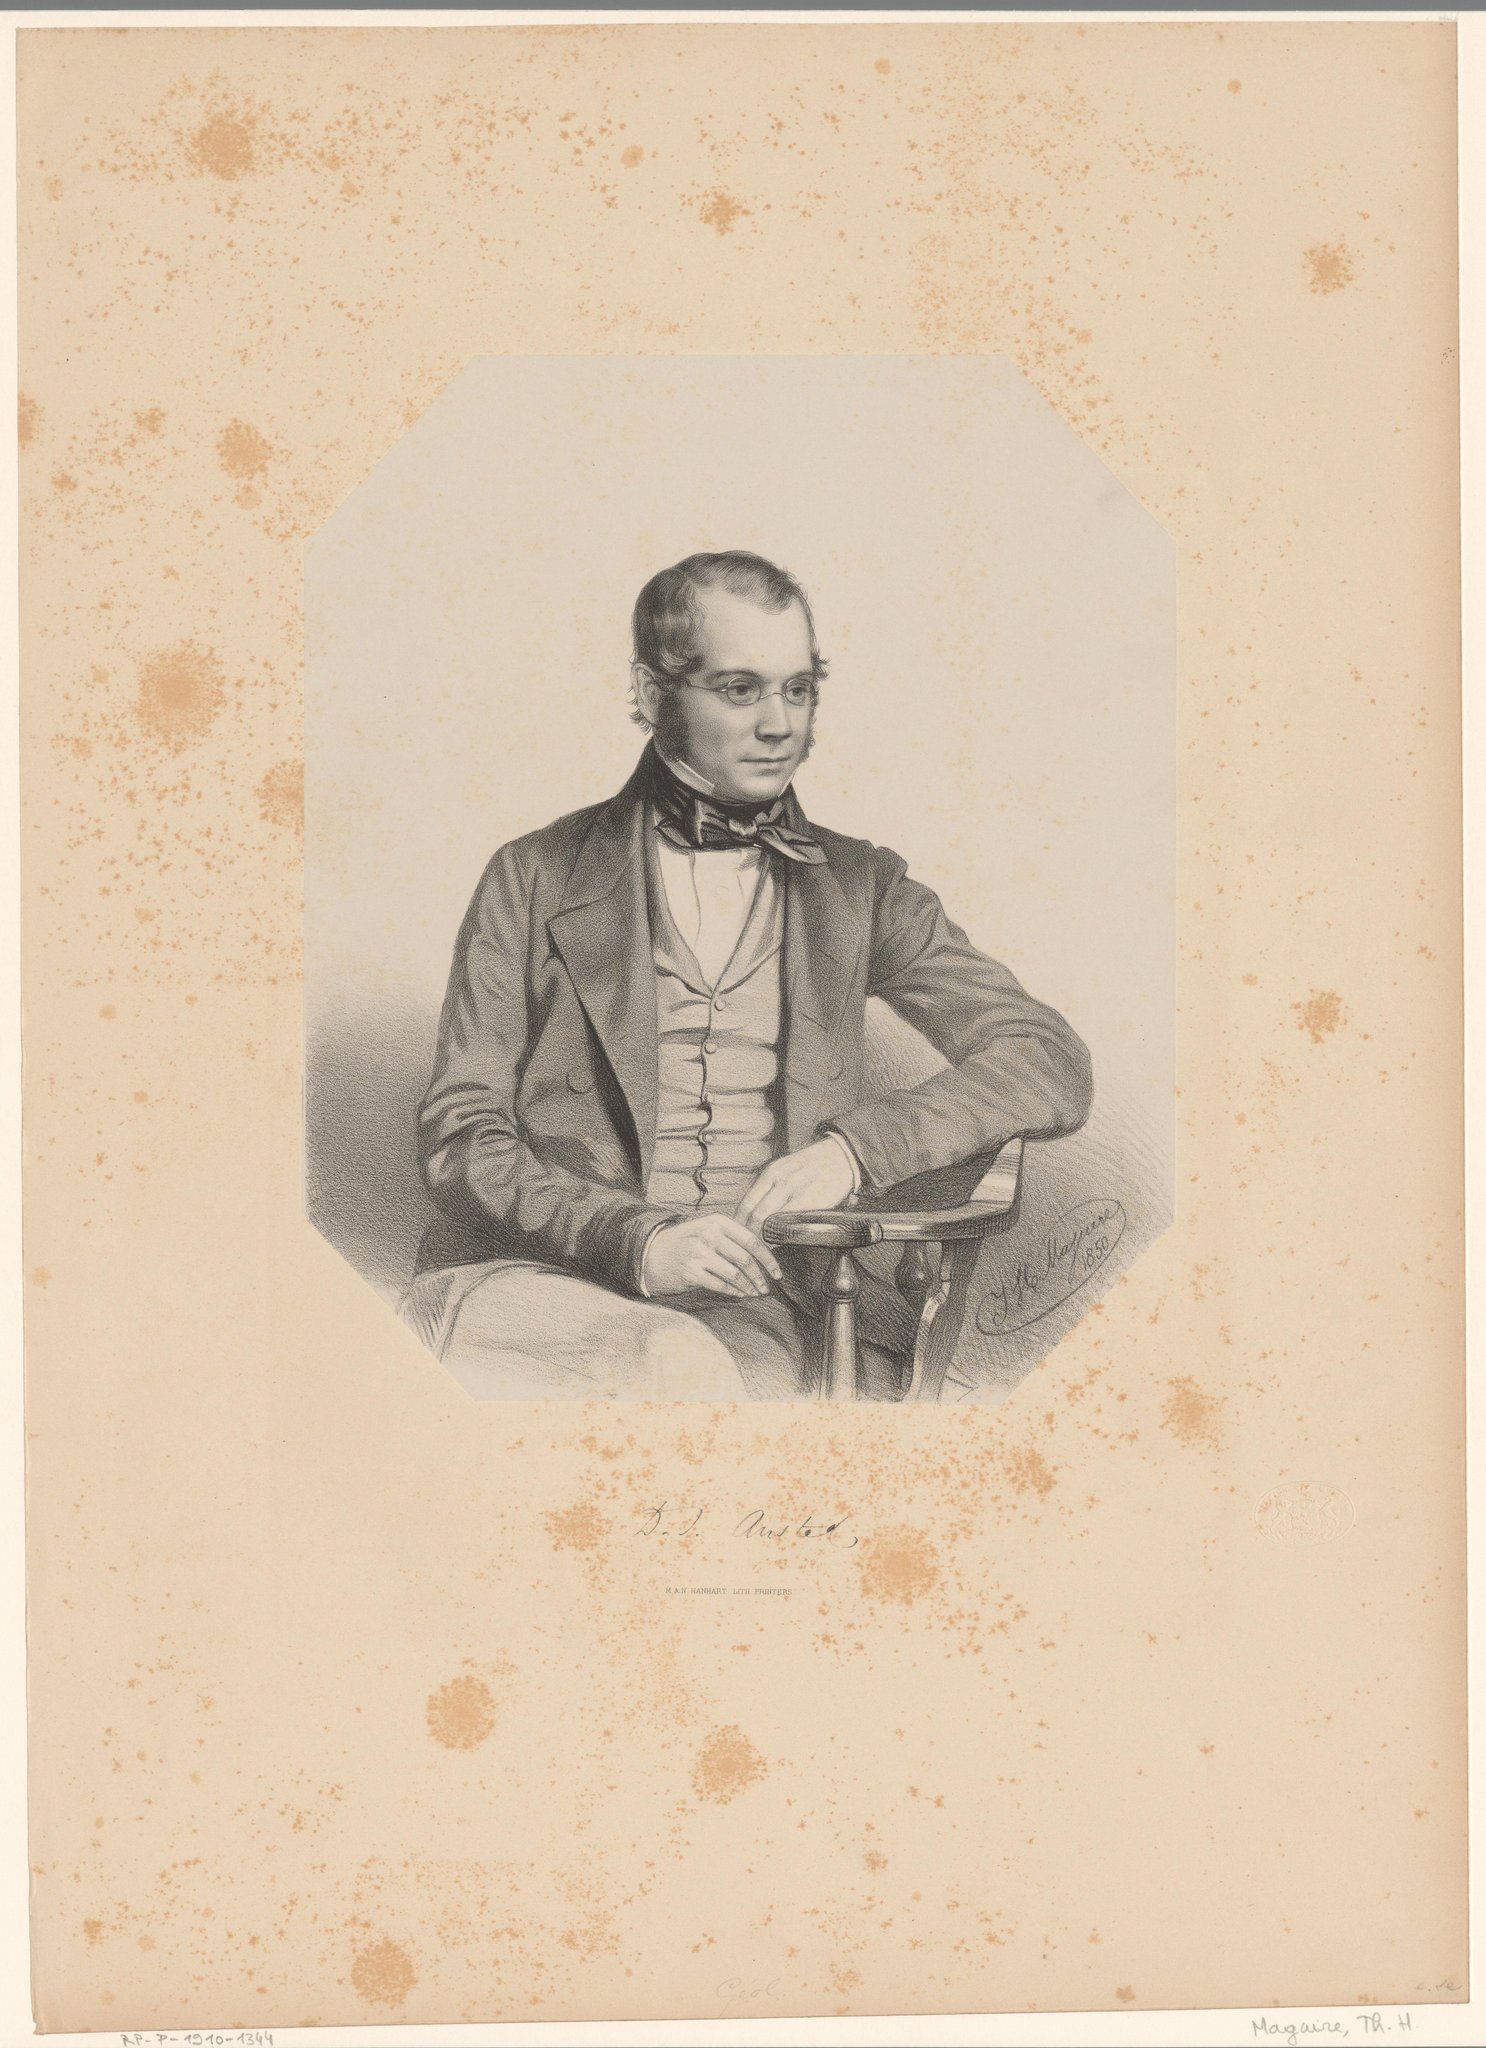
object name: print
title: Portretten uit het Ipswich Museum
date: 1852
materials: paper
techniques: lithograph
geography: london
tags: eyeglasses, spectacles, adult man, historical persons, chair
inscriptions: collector's mark: Lugt 2228, check stamp: ‘Ipswich Museum’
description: Prent behoort tot de serie 'Ipswich Museum Portraits', ook bekend onder de titel 'Portraits of Honorary Members of the Ipswich Museum'. Deze serie is in 1852 door George Ransome uitgegeven en gedrukt door M&N Hanhart tussen 1848 en 1852. De serie bestaat uit ca. 60 portretten.